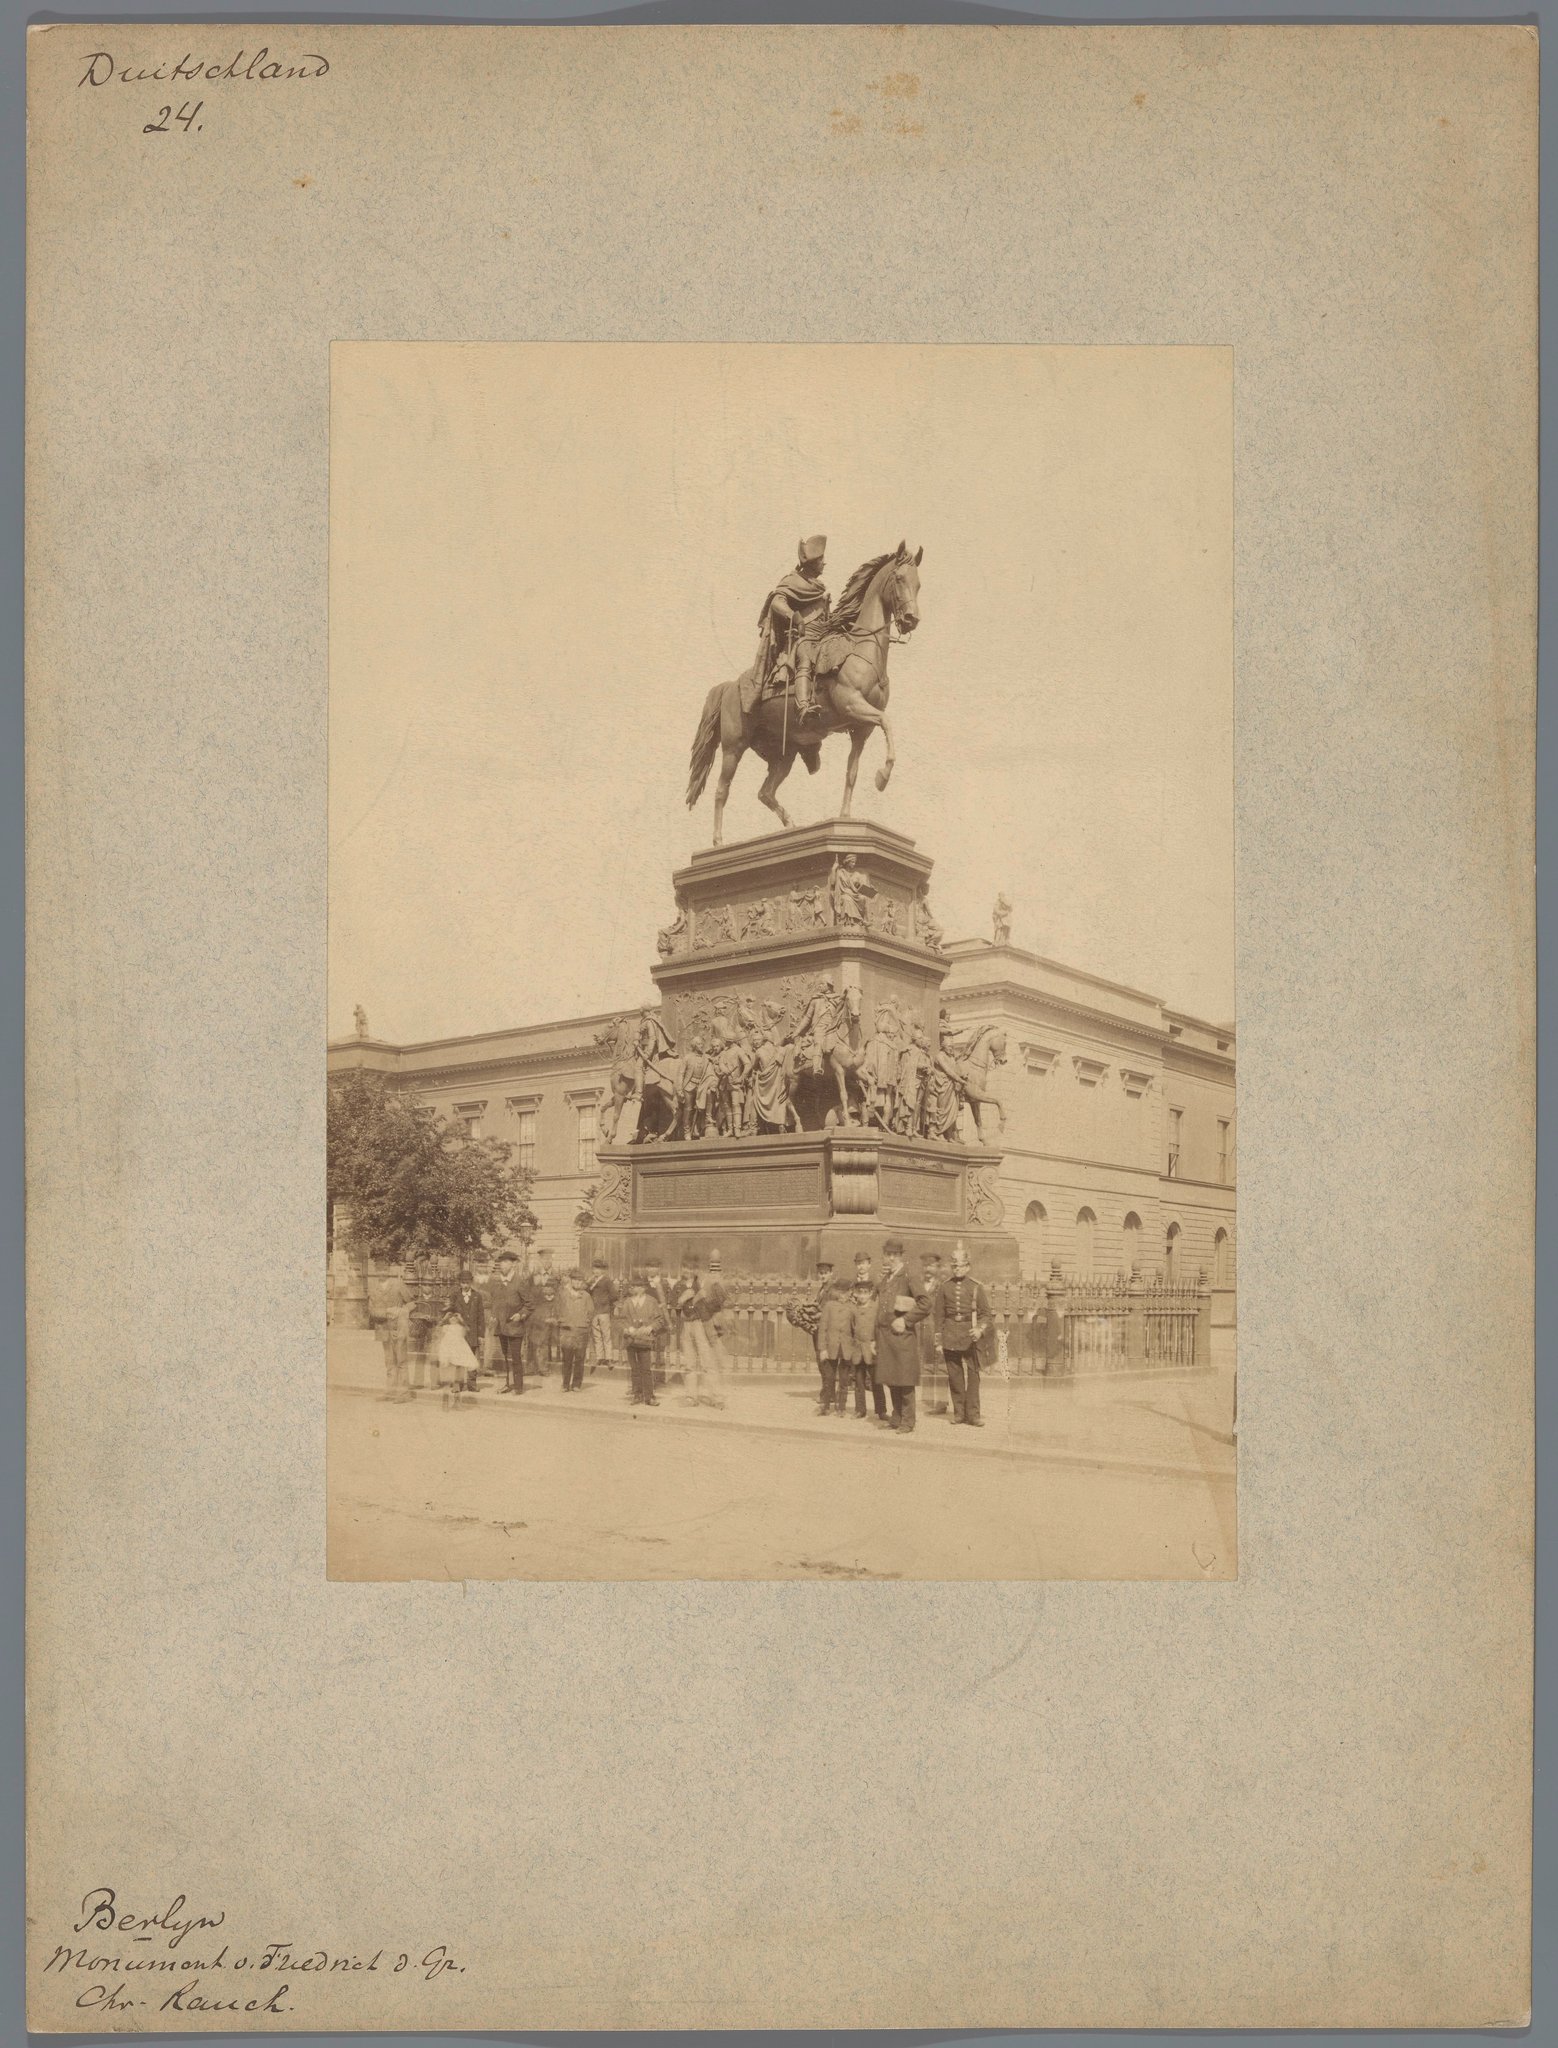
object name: photograph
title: Groepsportret voor het monument ter ere van Fredrik de Grote te Berlijn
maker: Anonymous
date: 1850-1900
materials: cardboard, photographic support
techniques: albumen print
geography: berlin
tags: monument, statue, historical persons not known by name, berlin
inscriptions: inscription: ‘Berlijn/ Monument v. Friedrick d. Gr./ Chr Rauch’, collector's mark: ‘Rijks normaalschool voor teekenonderwijzers Amsterdam’, inscription: ‘Duitschland/ 24.’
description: Monument ontworpen door Christian Daniel Rauch.